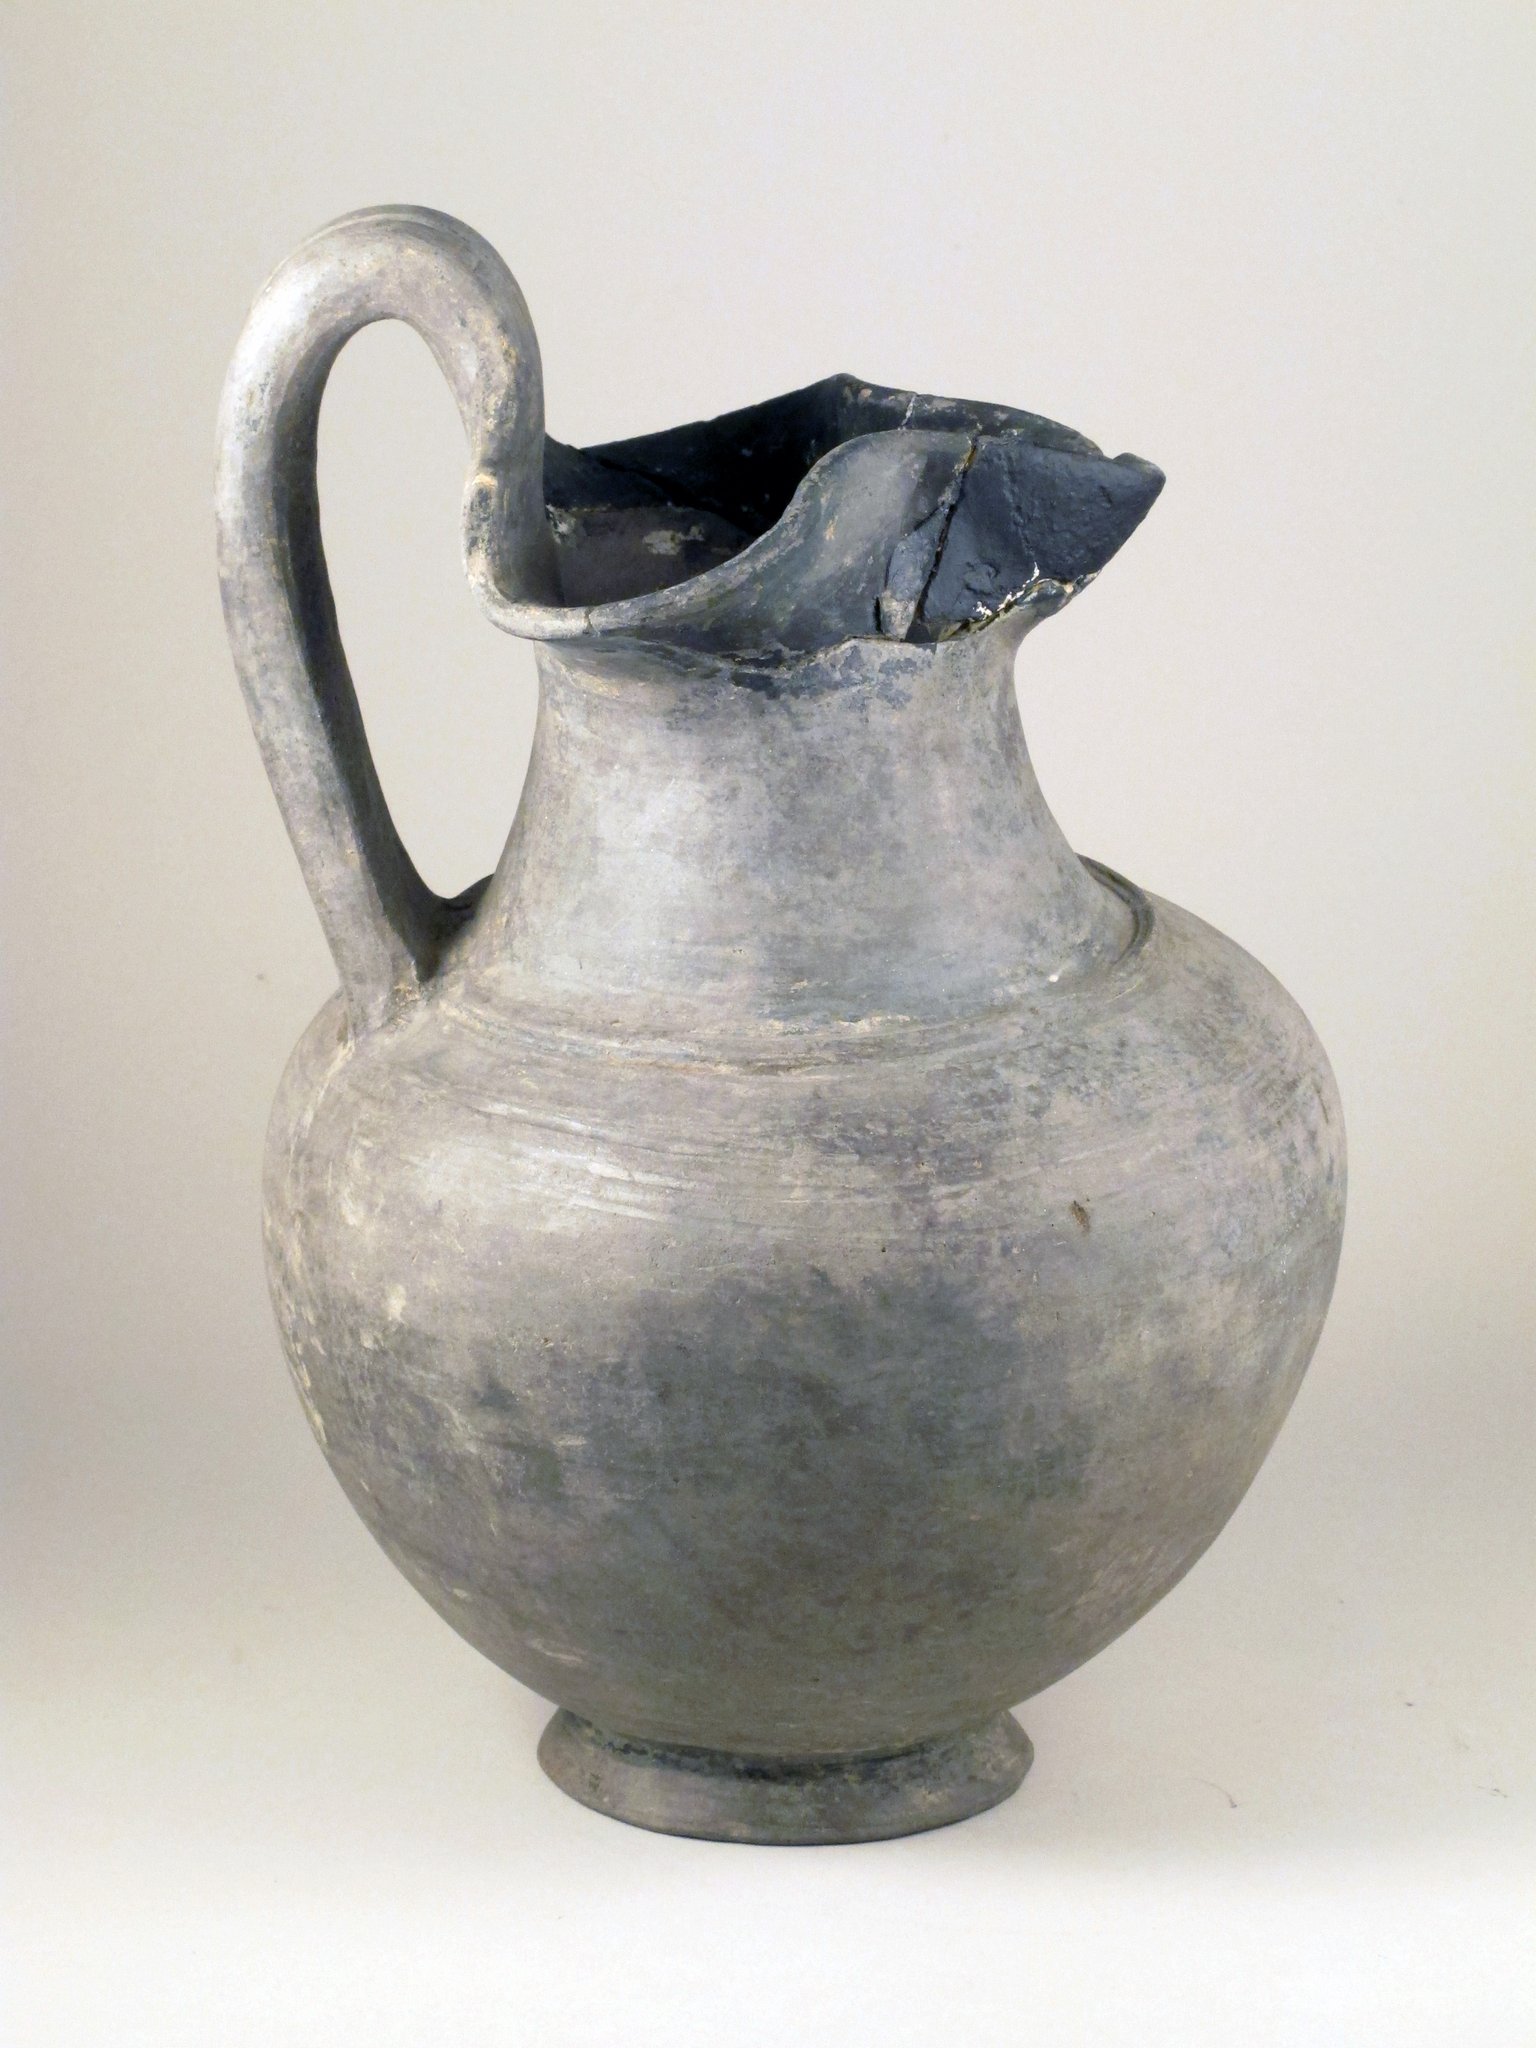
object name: jug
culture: etruscan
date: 650-626 BCE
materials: terracotta